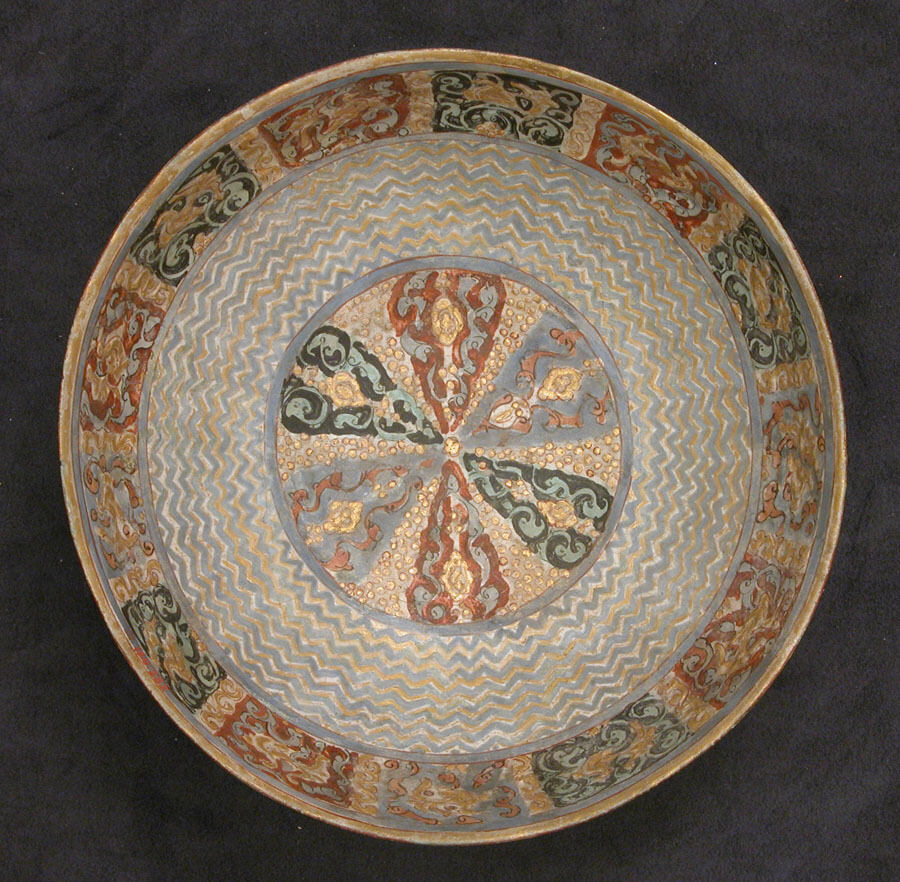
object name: bowl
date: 1101-1300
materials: stonepaste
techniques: gilding, overglaze, painting, polychrome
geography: iran